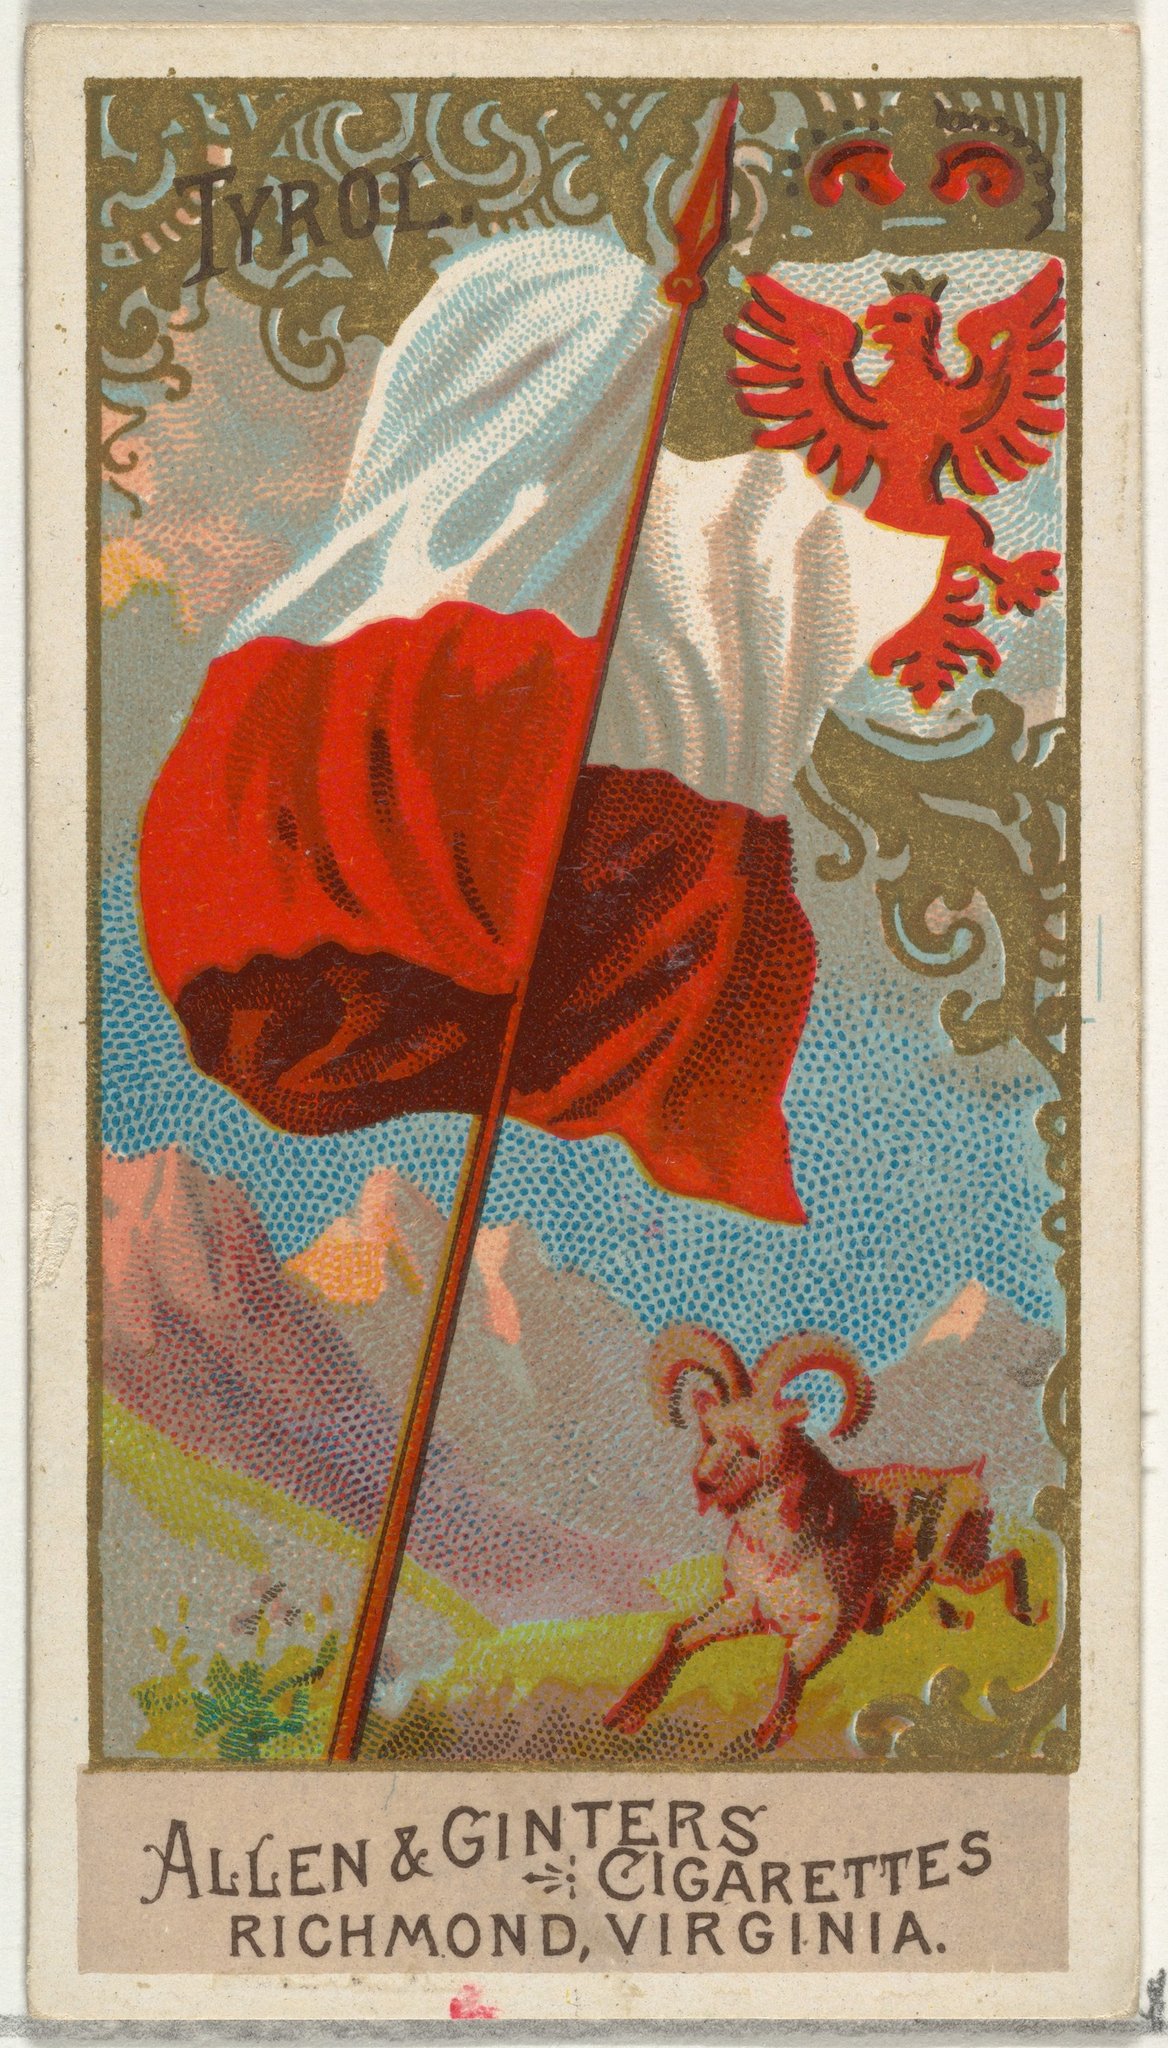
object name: print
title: Tyrol, from Flags of All Nations, Series 2 (N10) for Allen & Ginter Cigarettes Brands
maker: allen & ginter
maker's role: publisher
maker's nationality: american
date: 1890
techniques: color lithograph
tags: flags